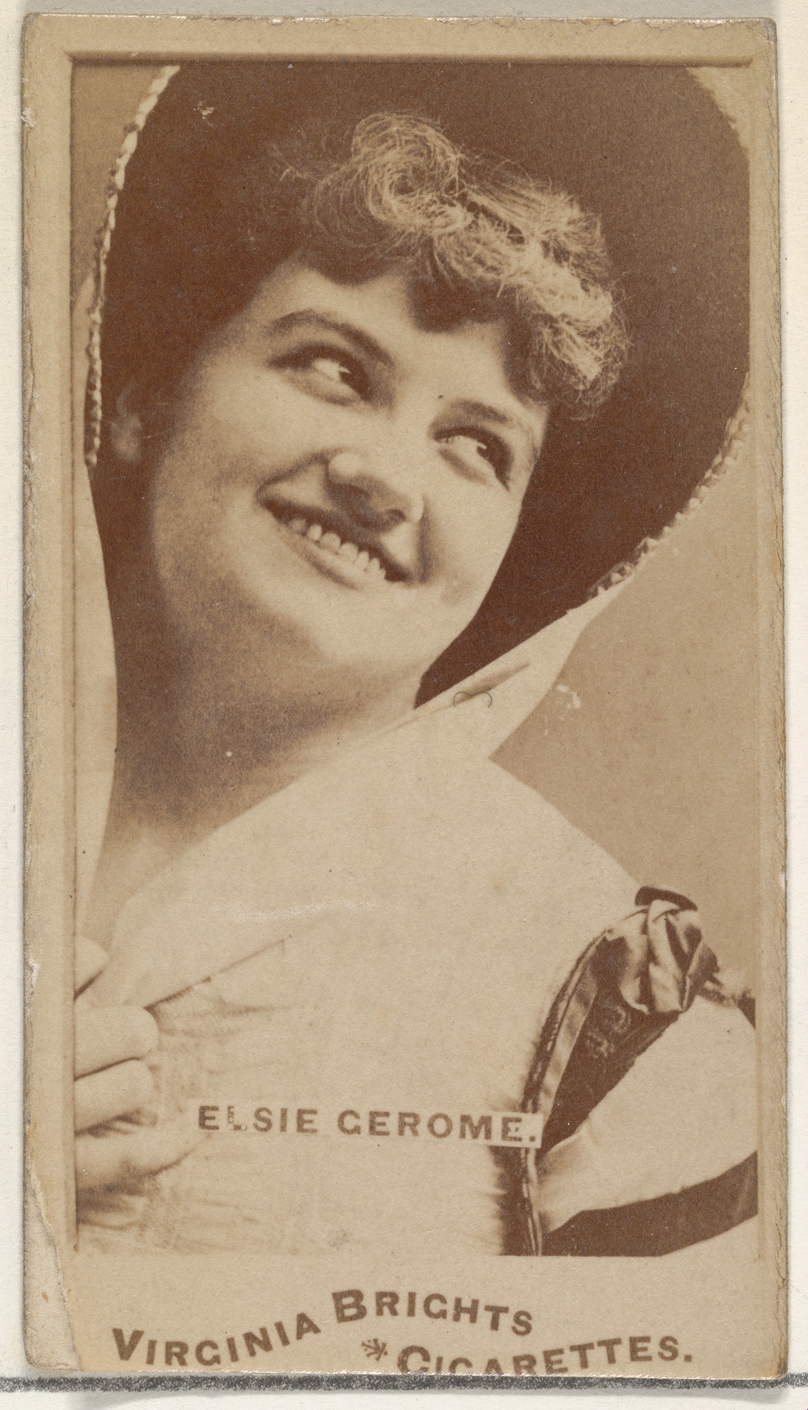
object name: photograph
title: Elsie Gerome, from the Actors and Actresses series (N45, Type 1) for Virginia Brights Cigarettes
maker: allen & ginter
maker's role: publisher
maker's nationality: american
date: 1888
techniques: albumen silver print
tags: portraits,women,actresses